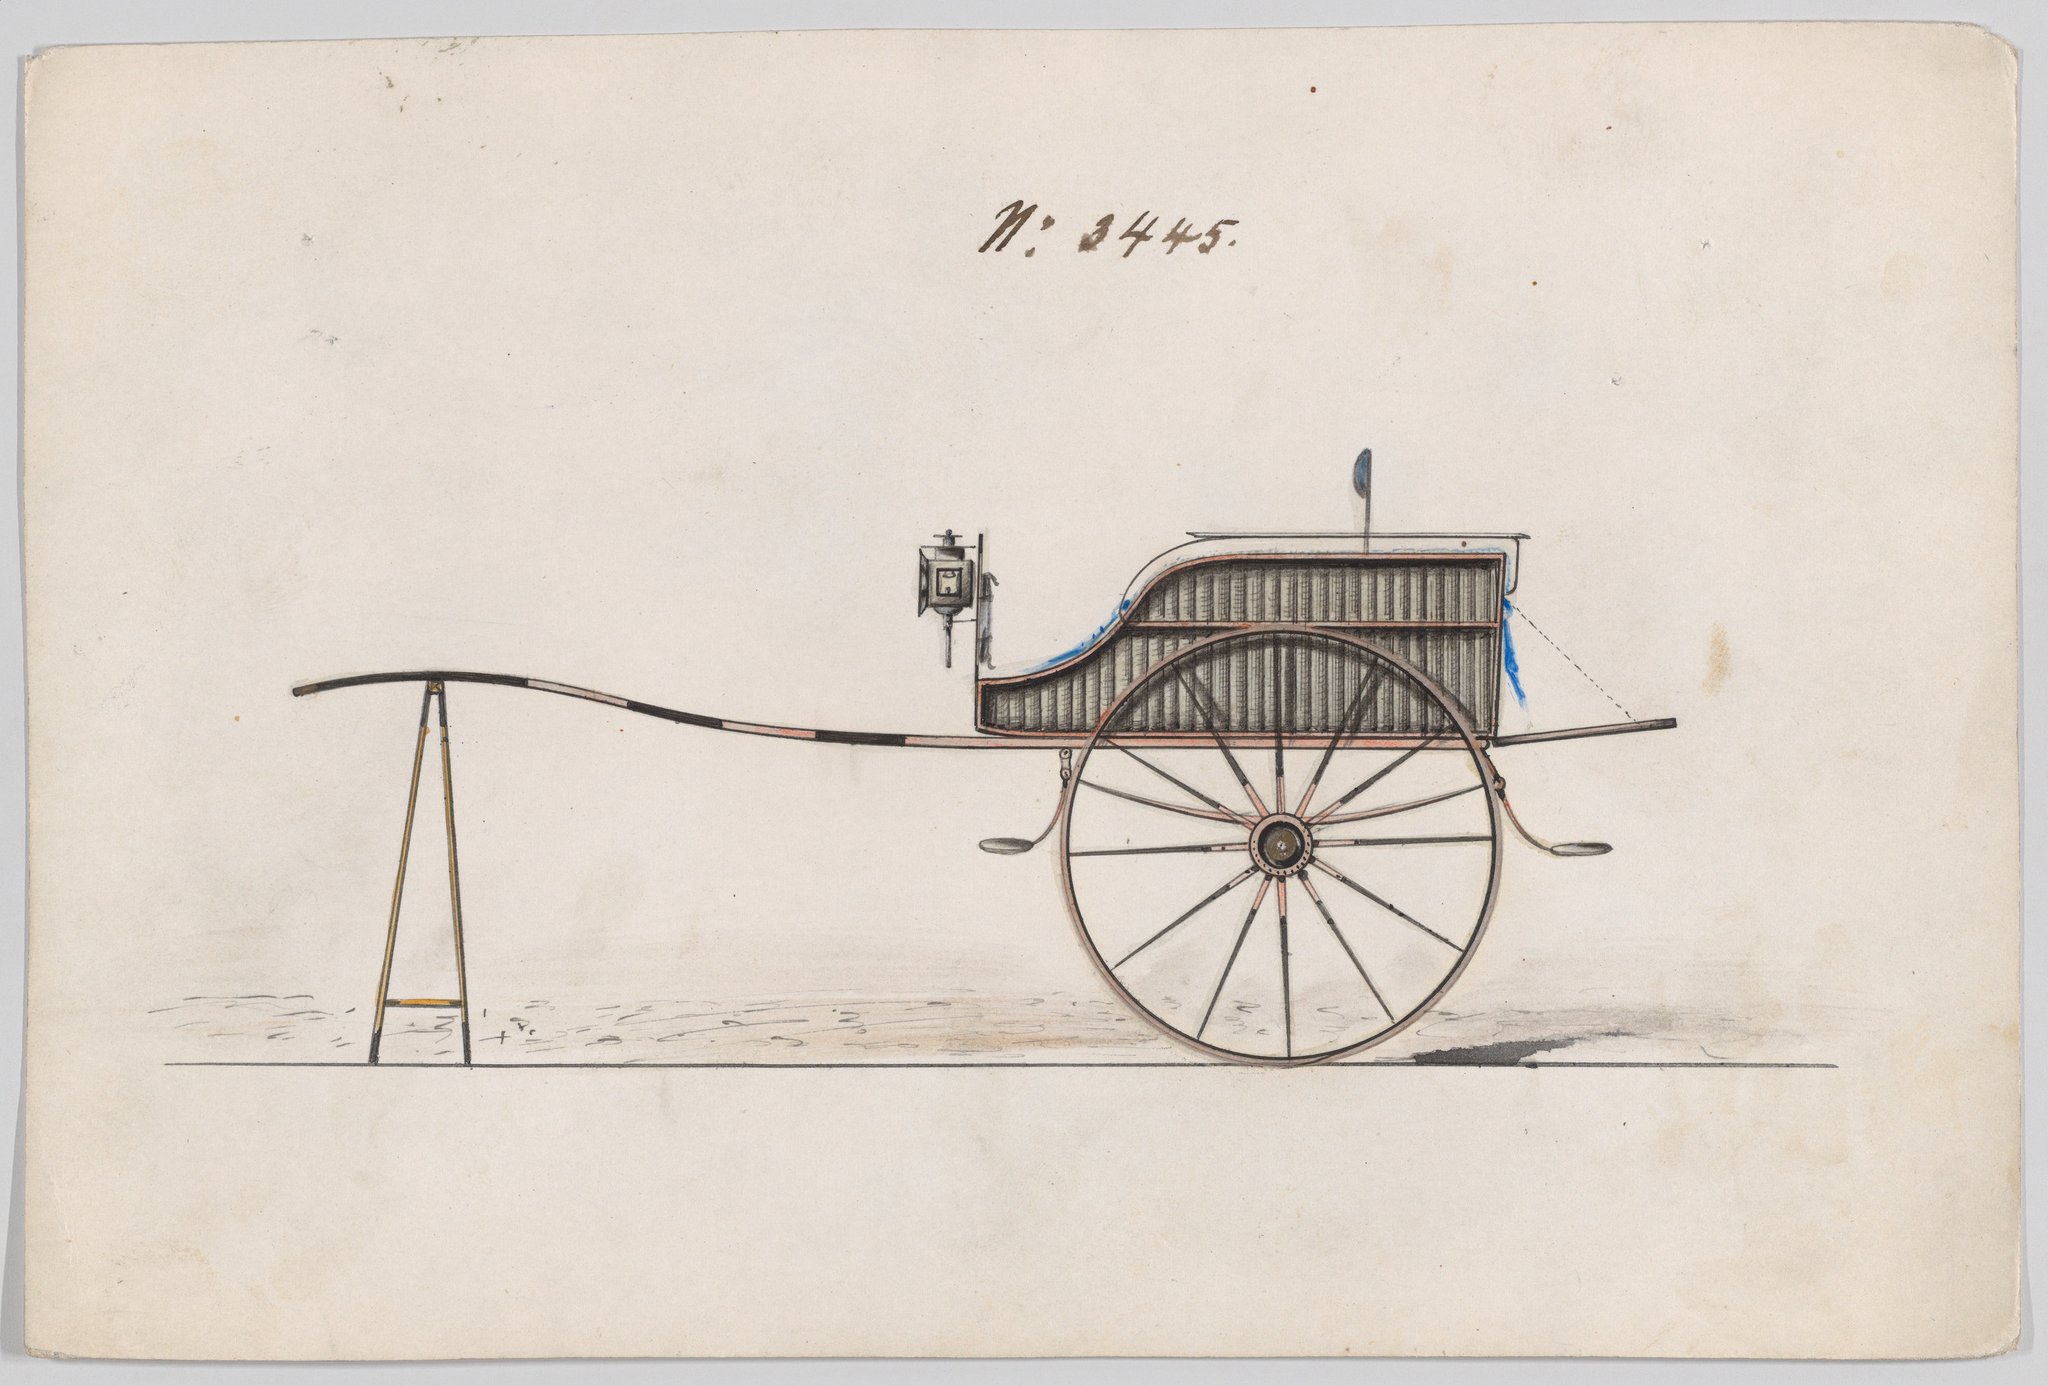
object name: drawing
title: Villiage Cart #3445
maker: brewster & co.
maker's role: manufacturer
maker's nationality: american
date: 1878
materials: gouache, gum arabic, ink, watercolor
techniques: pen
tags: carriages